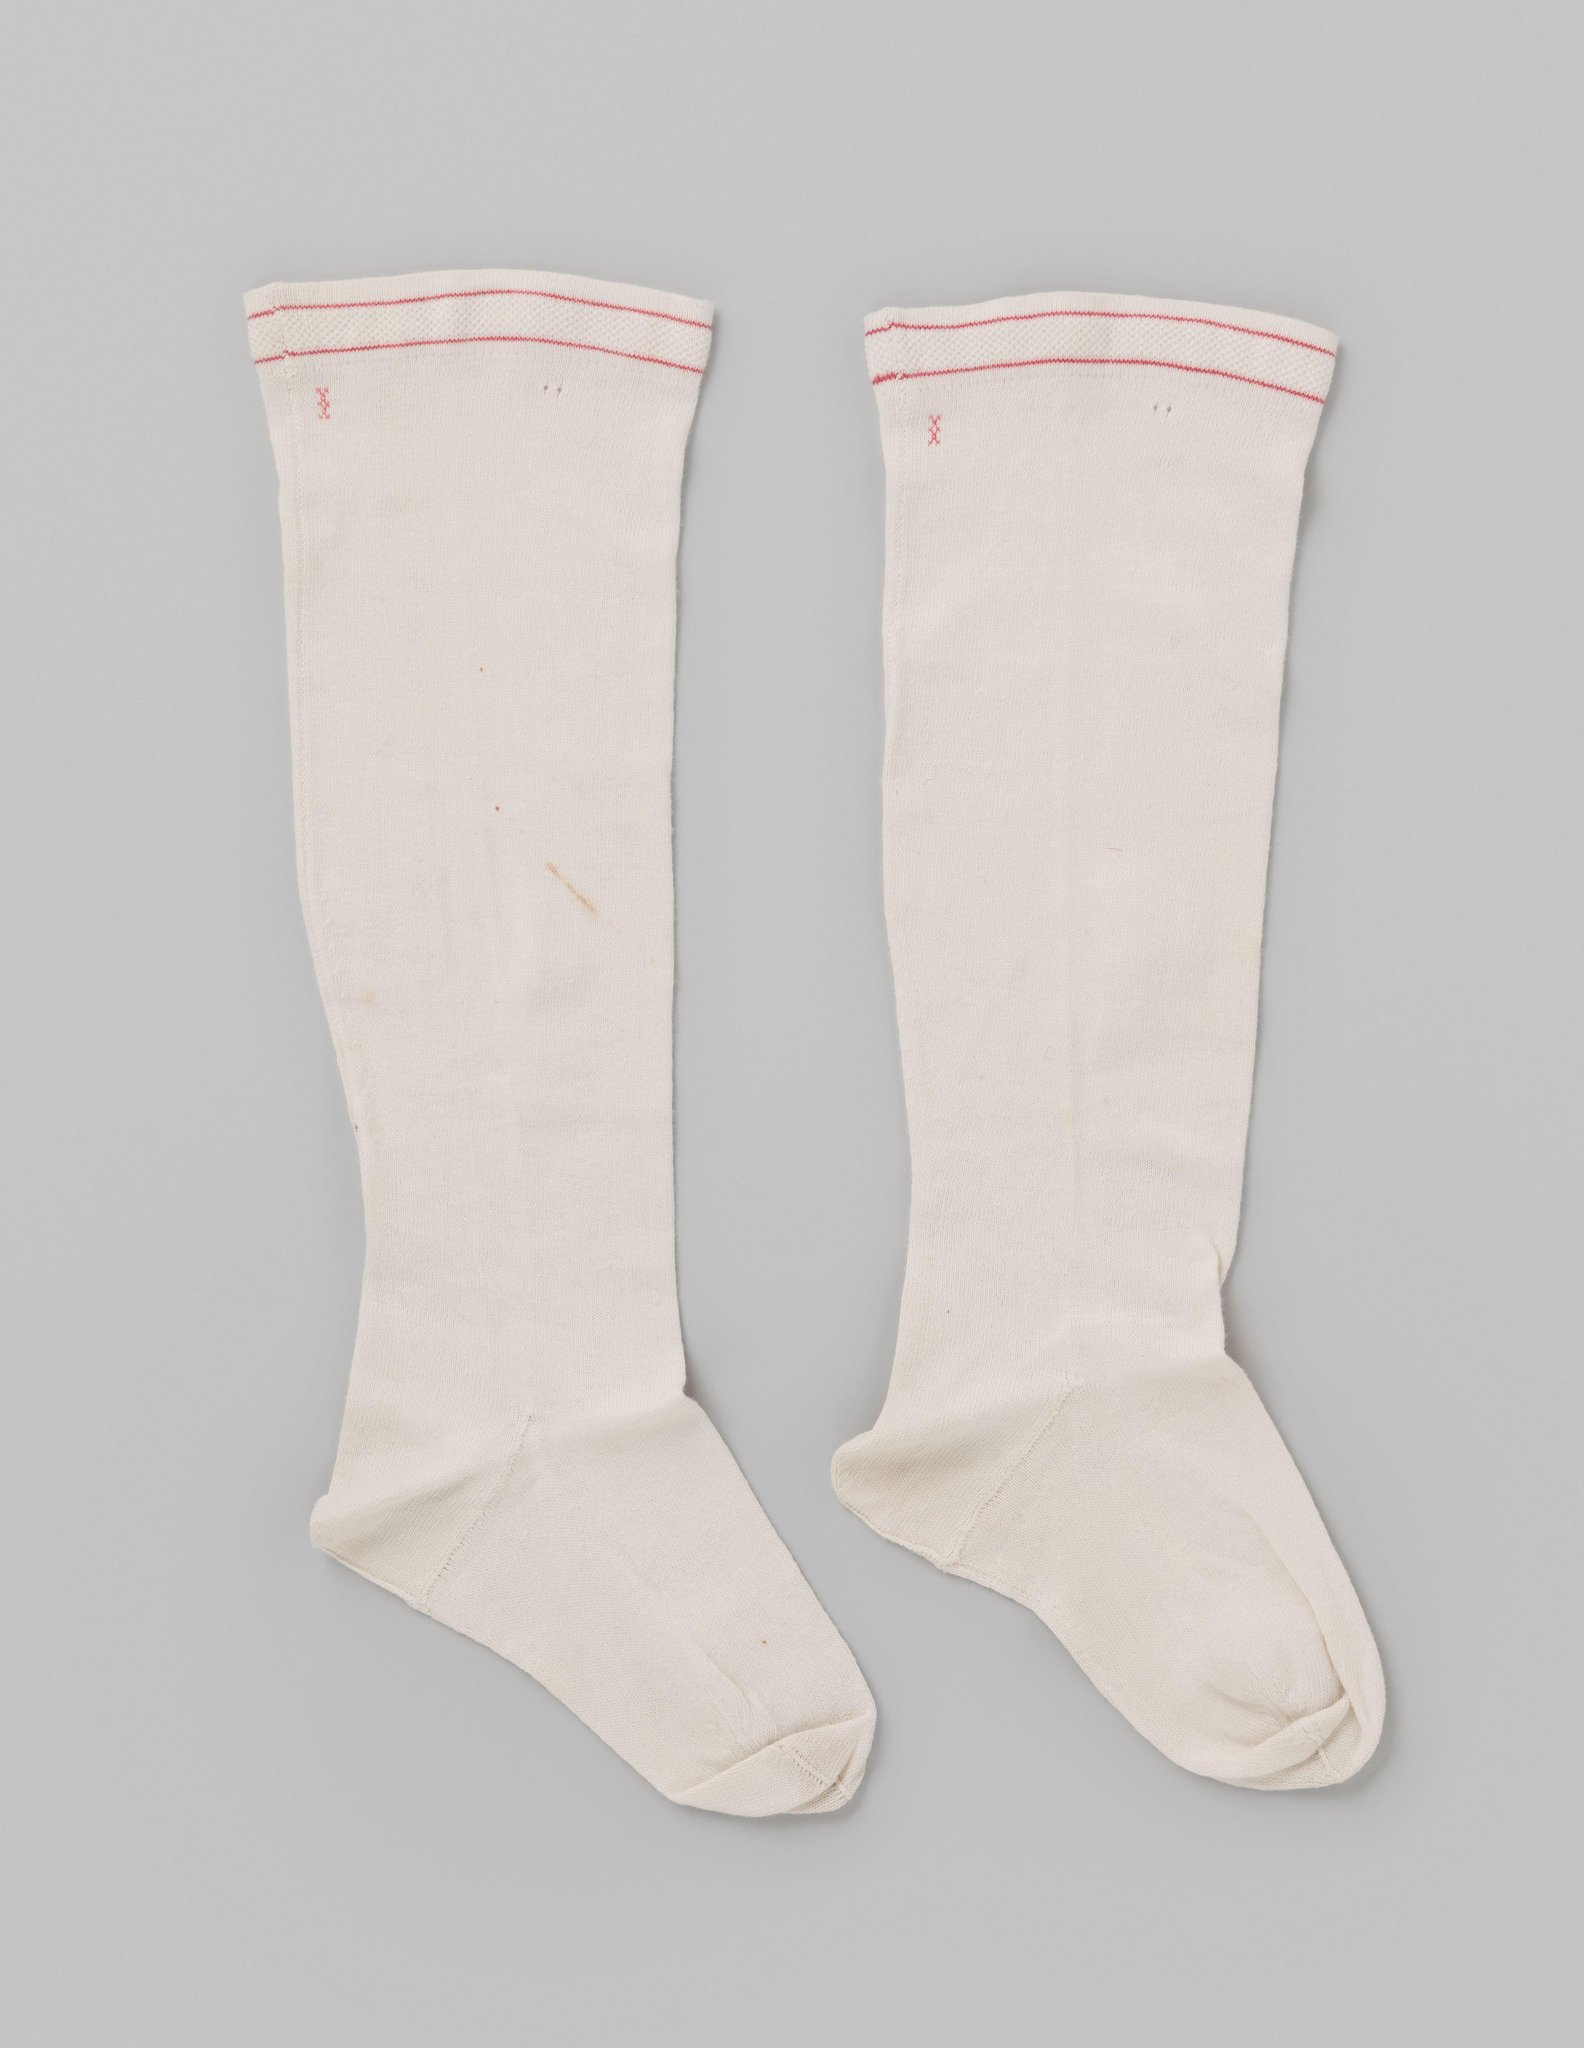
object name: stocking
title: Kous van effen witte katoenen tricot met in de boord twee rode strepen, waartussen een gerstekorrelsteek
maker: Anonymous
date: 1828-1830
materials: cotton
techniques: cross stitching, embroidered, knitting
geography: netherlands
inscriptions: mark: ‘'xx'’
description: Kous van effen witte katoenen tricot met in de boord twee rode strepen, waartussen een gerstekorrelsteek. Onder de boord in rode kruissteek: 'xx'.